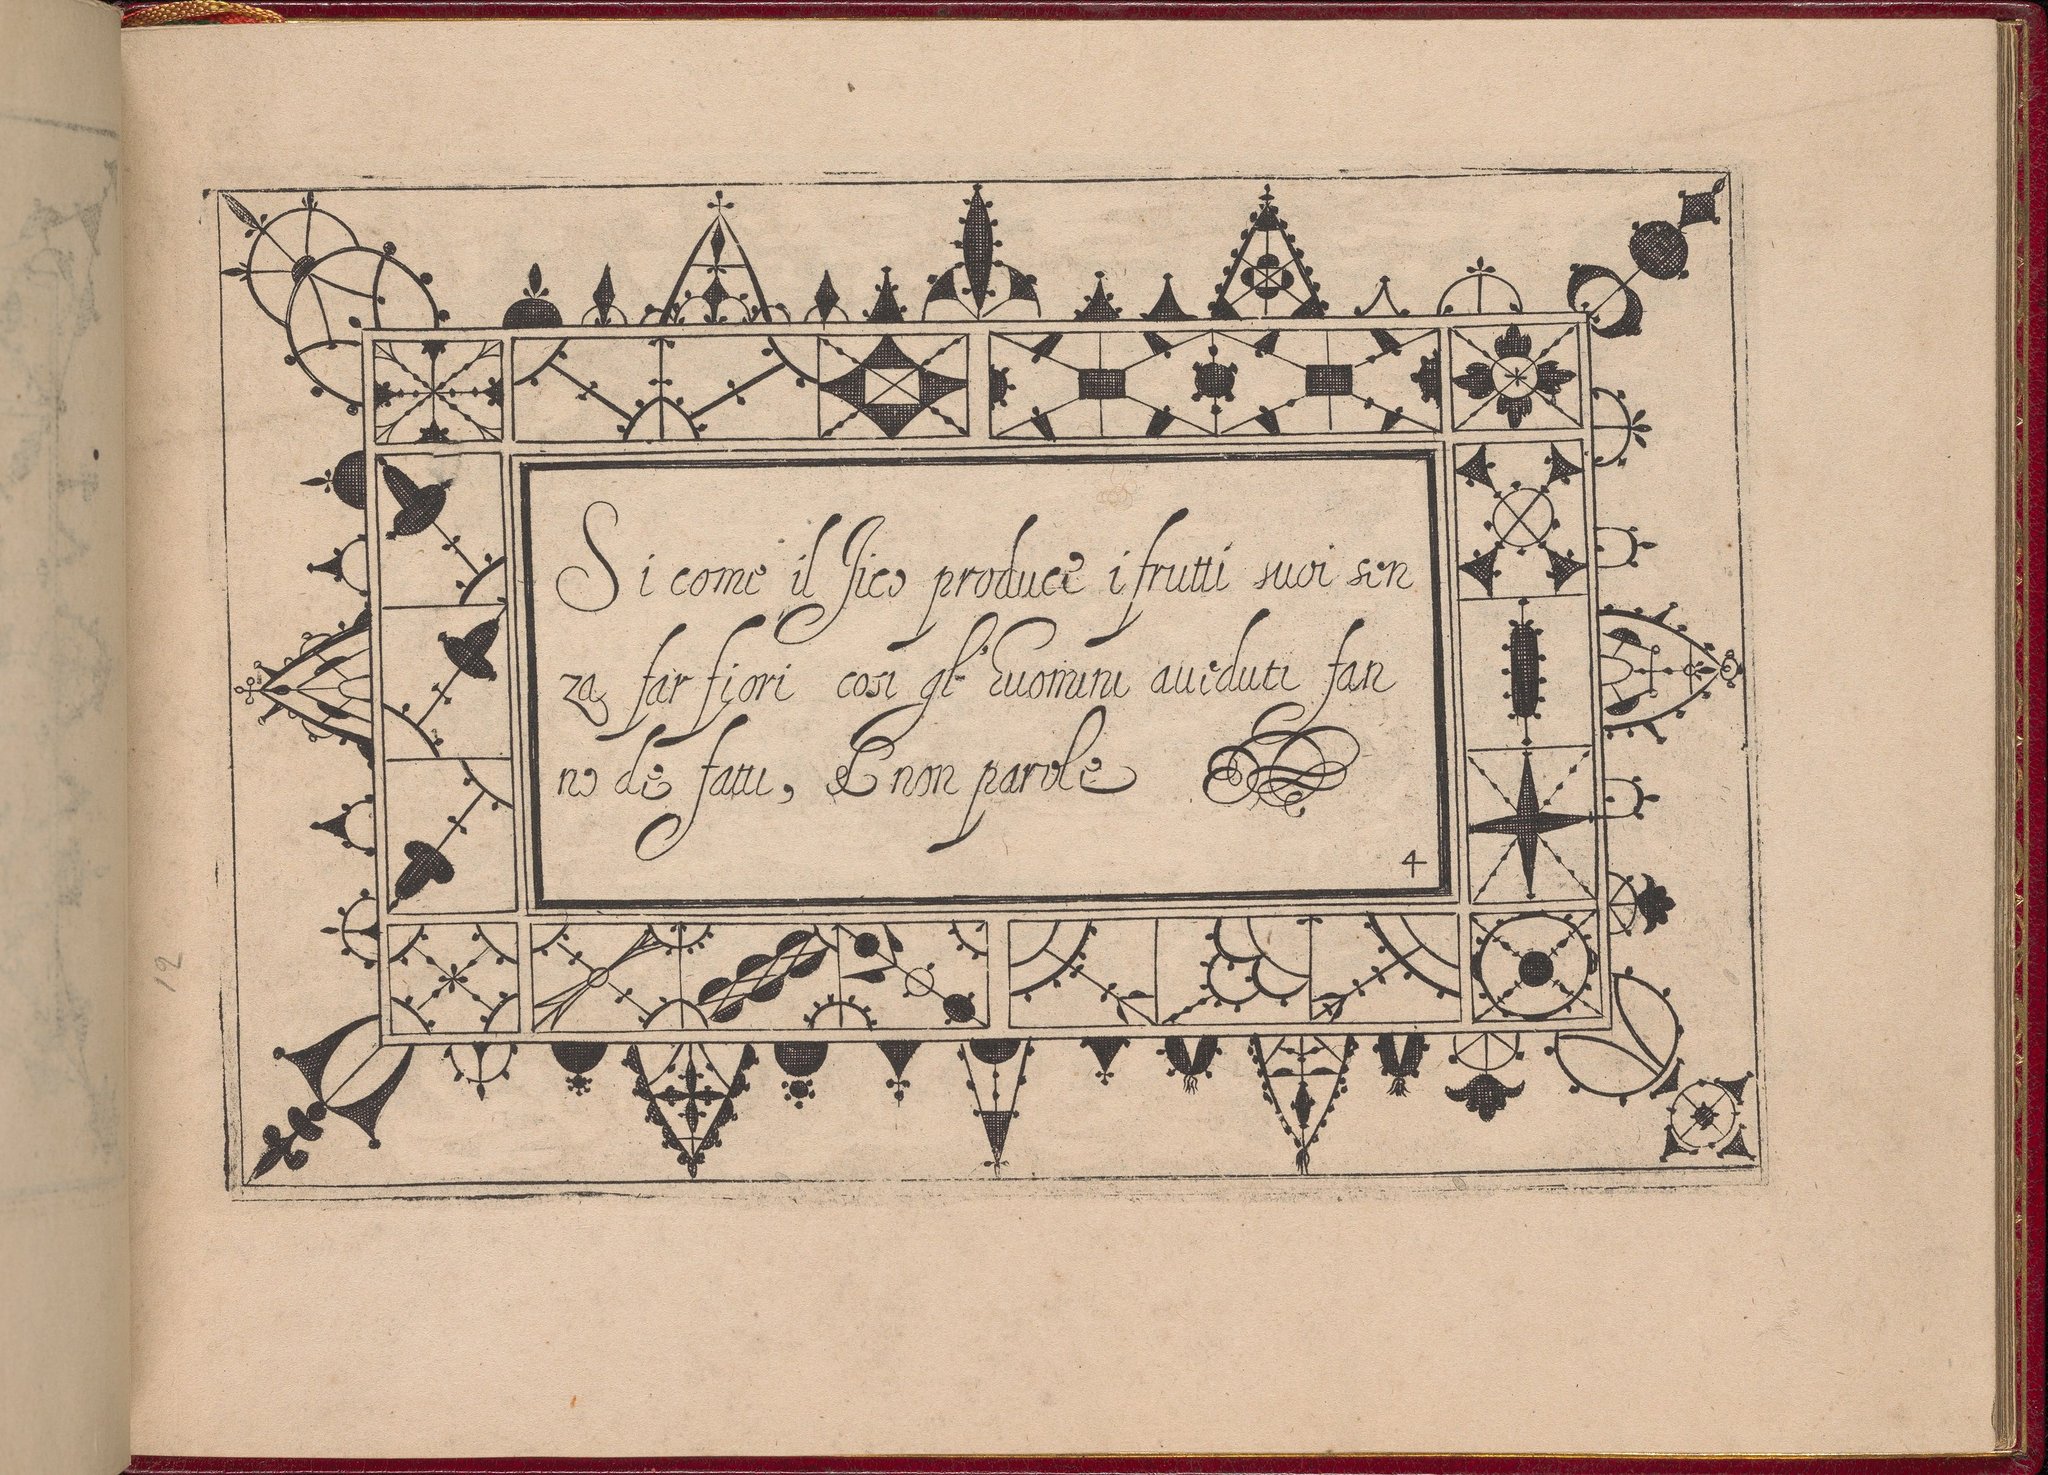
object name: book print ornament architecture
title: Ghirlanda: Di sei vaghi fiori scielti da piu famosi Giardini d'Italia, page 12 (recto)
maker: pietro paulo tozzi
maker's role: designer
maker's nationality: italian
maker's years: 1593-1628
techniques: drawing, etching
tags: ornament